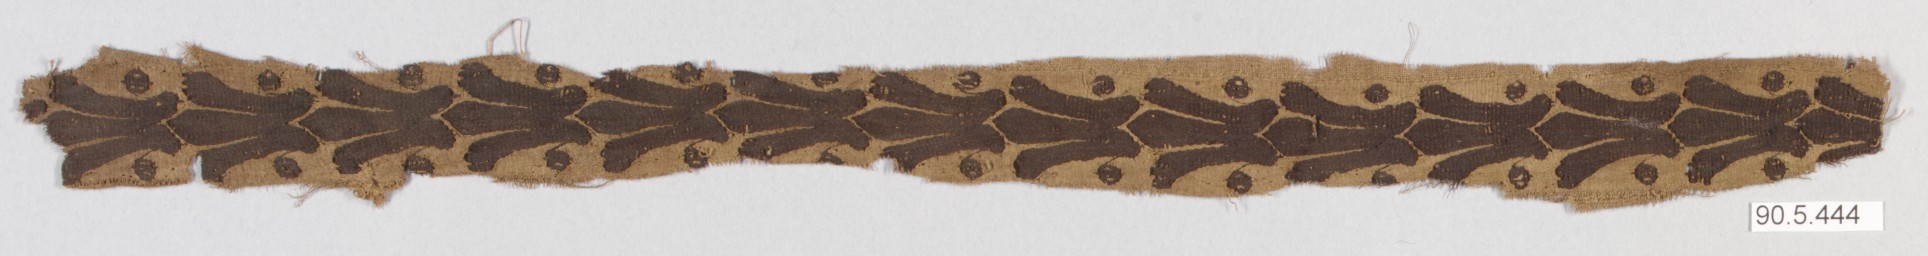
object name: textile fragment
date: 201-400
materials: linen, wool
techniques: weave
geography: egypt